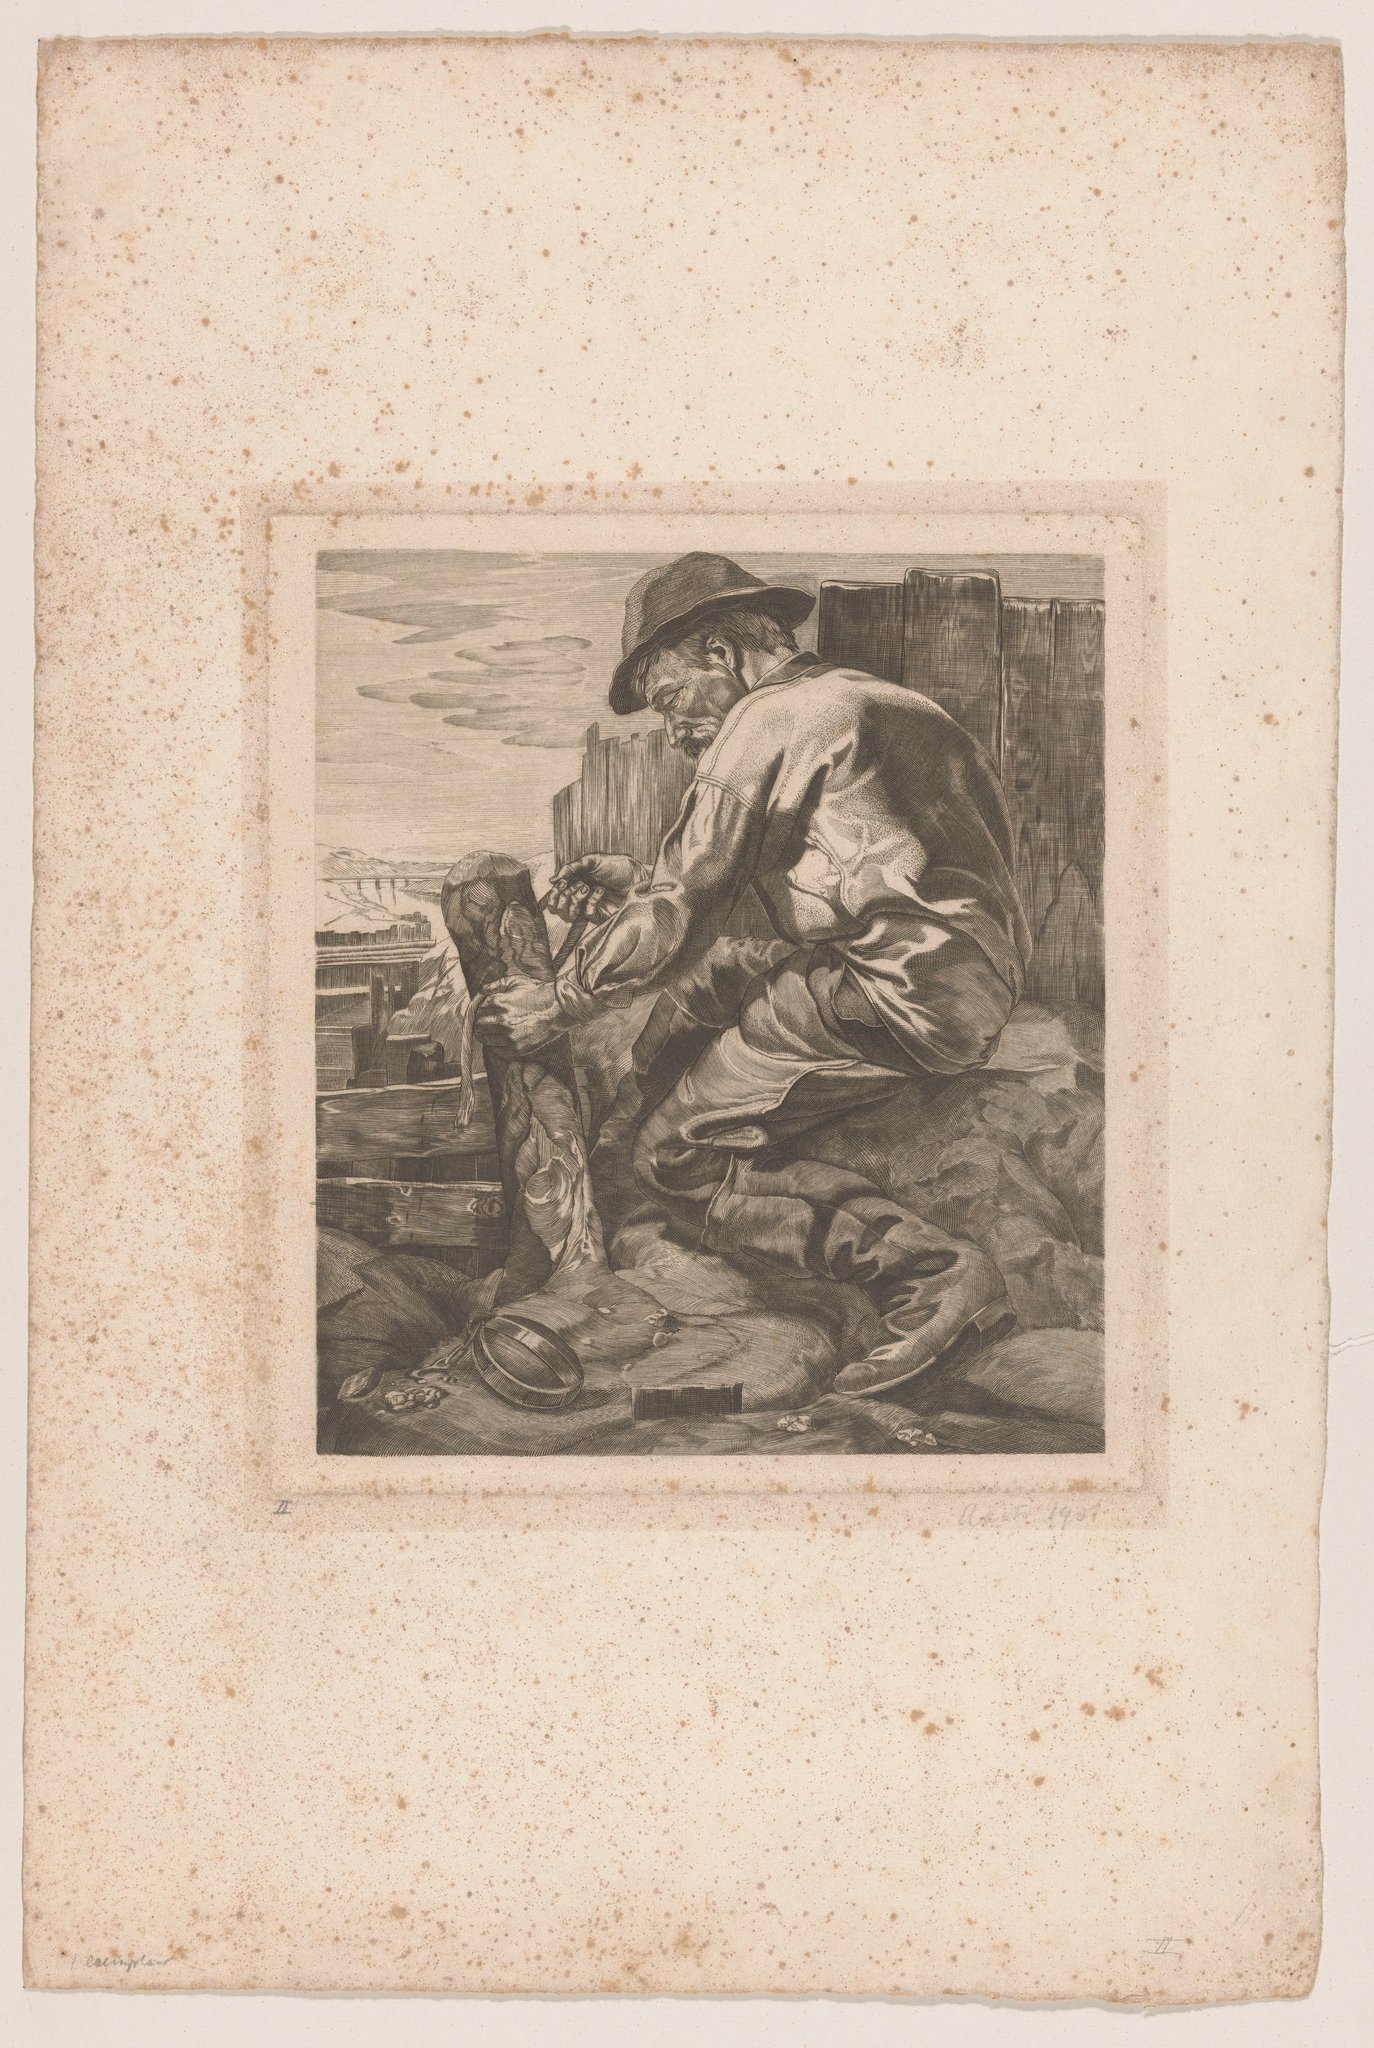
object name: print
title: Arbeider die een touw om een paal bindt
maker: johannes josephus aarts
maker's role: draughtsman, print maker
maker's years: 1871-1934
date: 1901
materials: paper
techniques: engraving, intaglio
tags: working class, labourers, tools, aids, implements ~ crafts and industries: rope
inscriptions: collector's mark: Lugt 2166, annotation: ‘1 exemplaar’, collector's mark: Lugt 2760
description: Een zittende man in werkkleding en en met hoed bindt een touw om een paal. Links op de achtergrond een rivier met een brug erover. Rechts op de achtergrond een houten schutting.